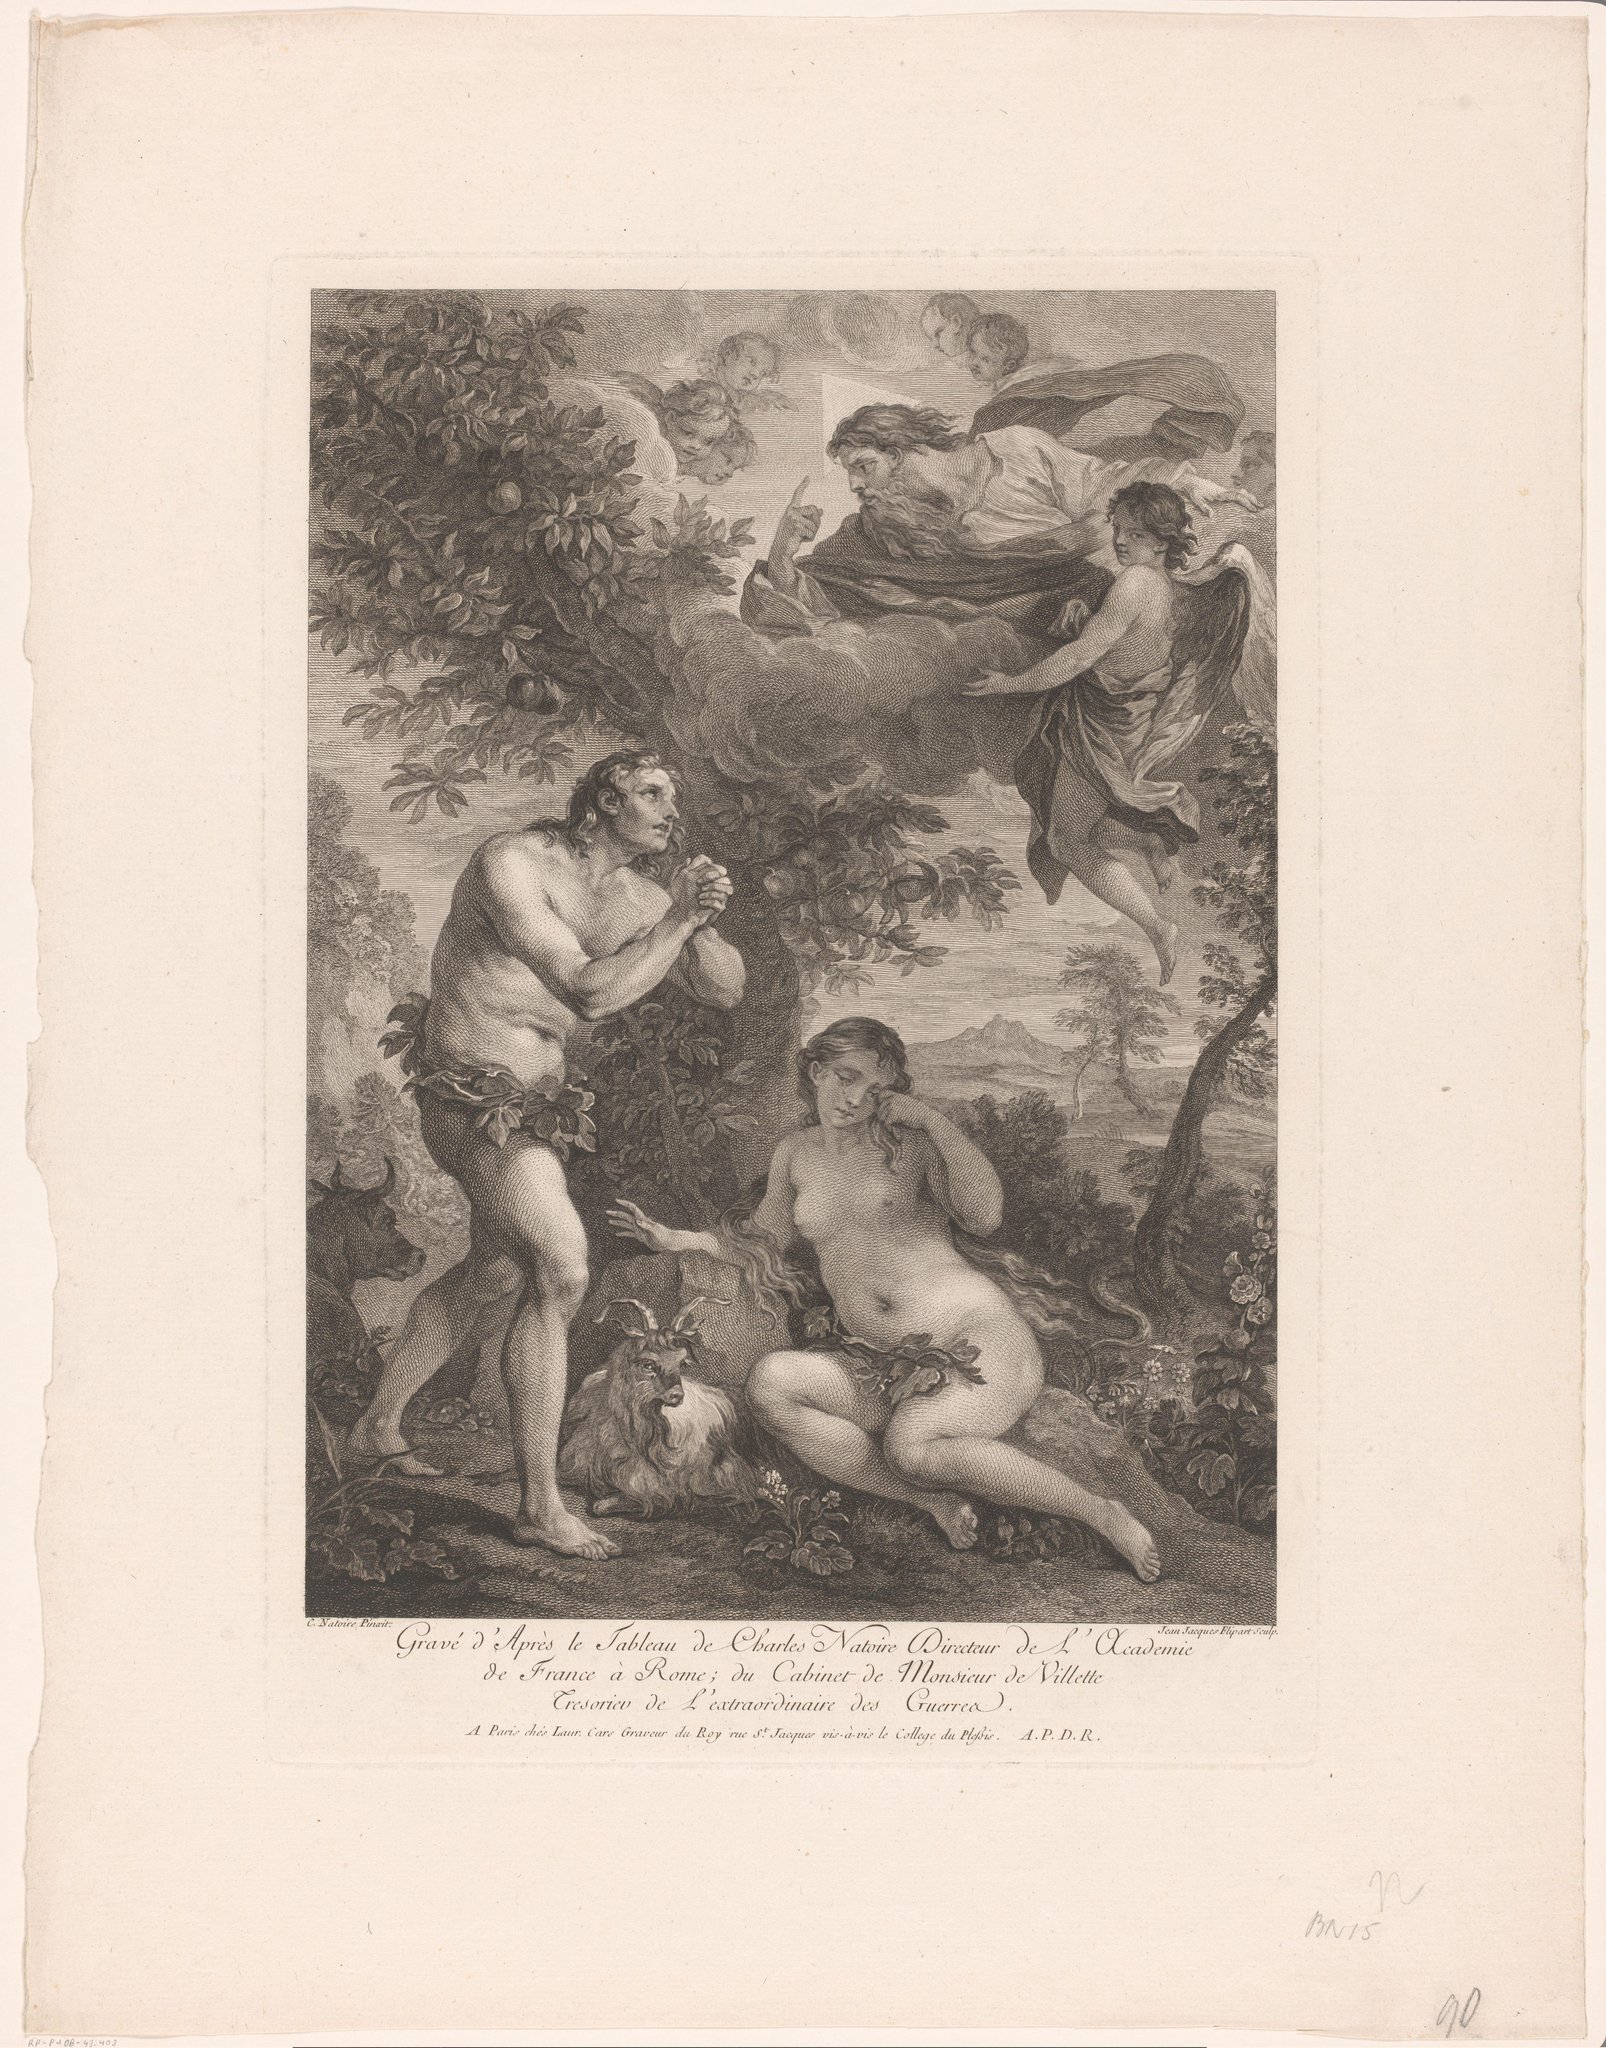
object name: print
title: Adam en Eva na de zondeval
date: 1755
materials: paper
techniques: engraving, etching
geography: paris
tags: temptation and fall (scenes with both adam and eve)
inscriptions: collector's mark: Lugt 2228